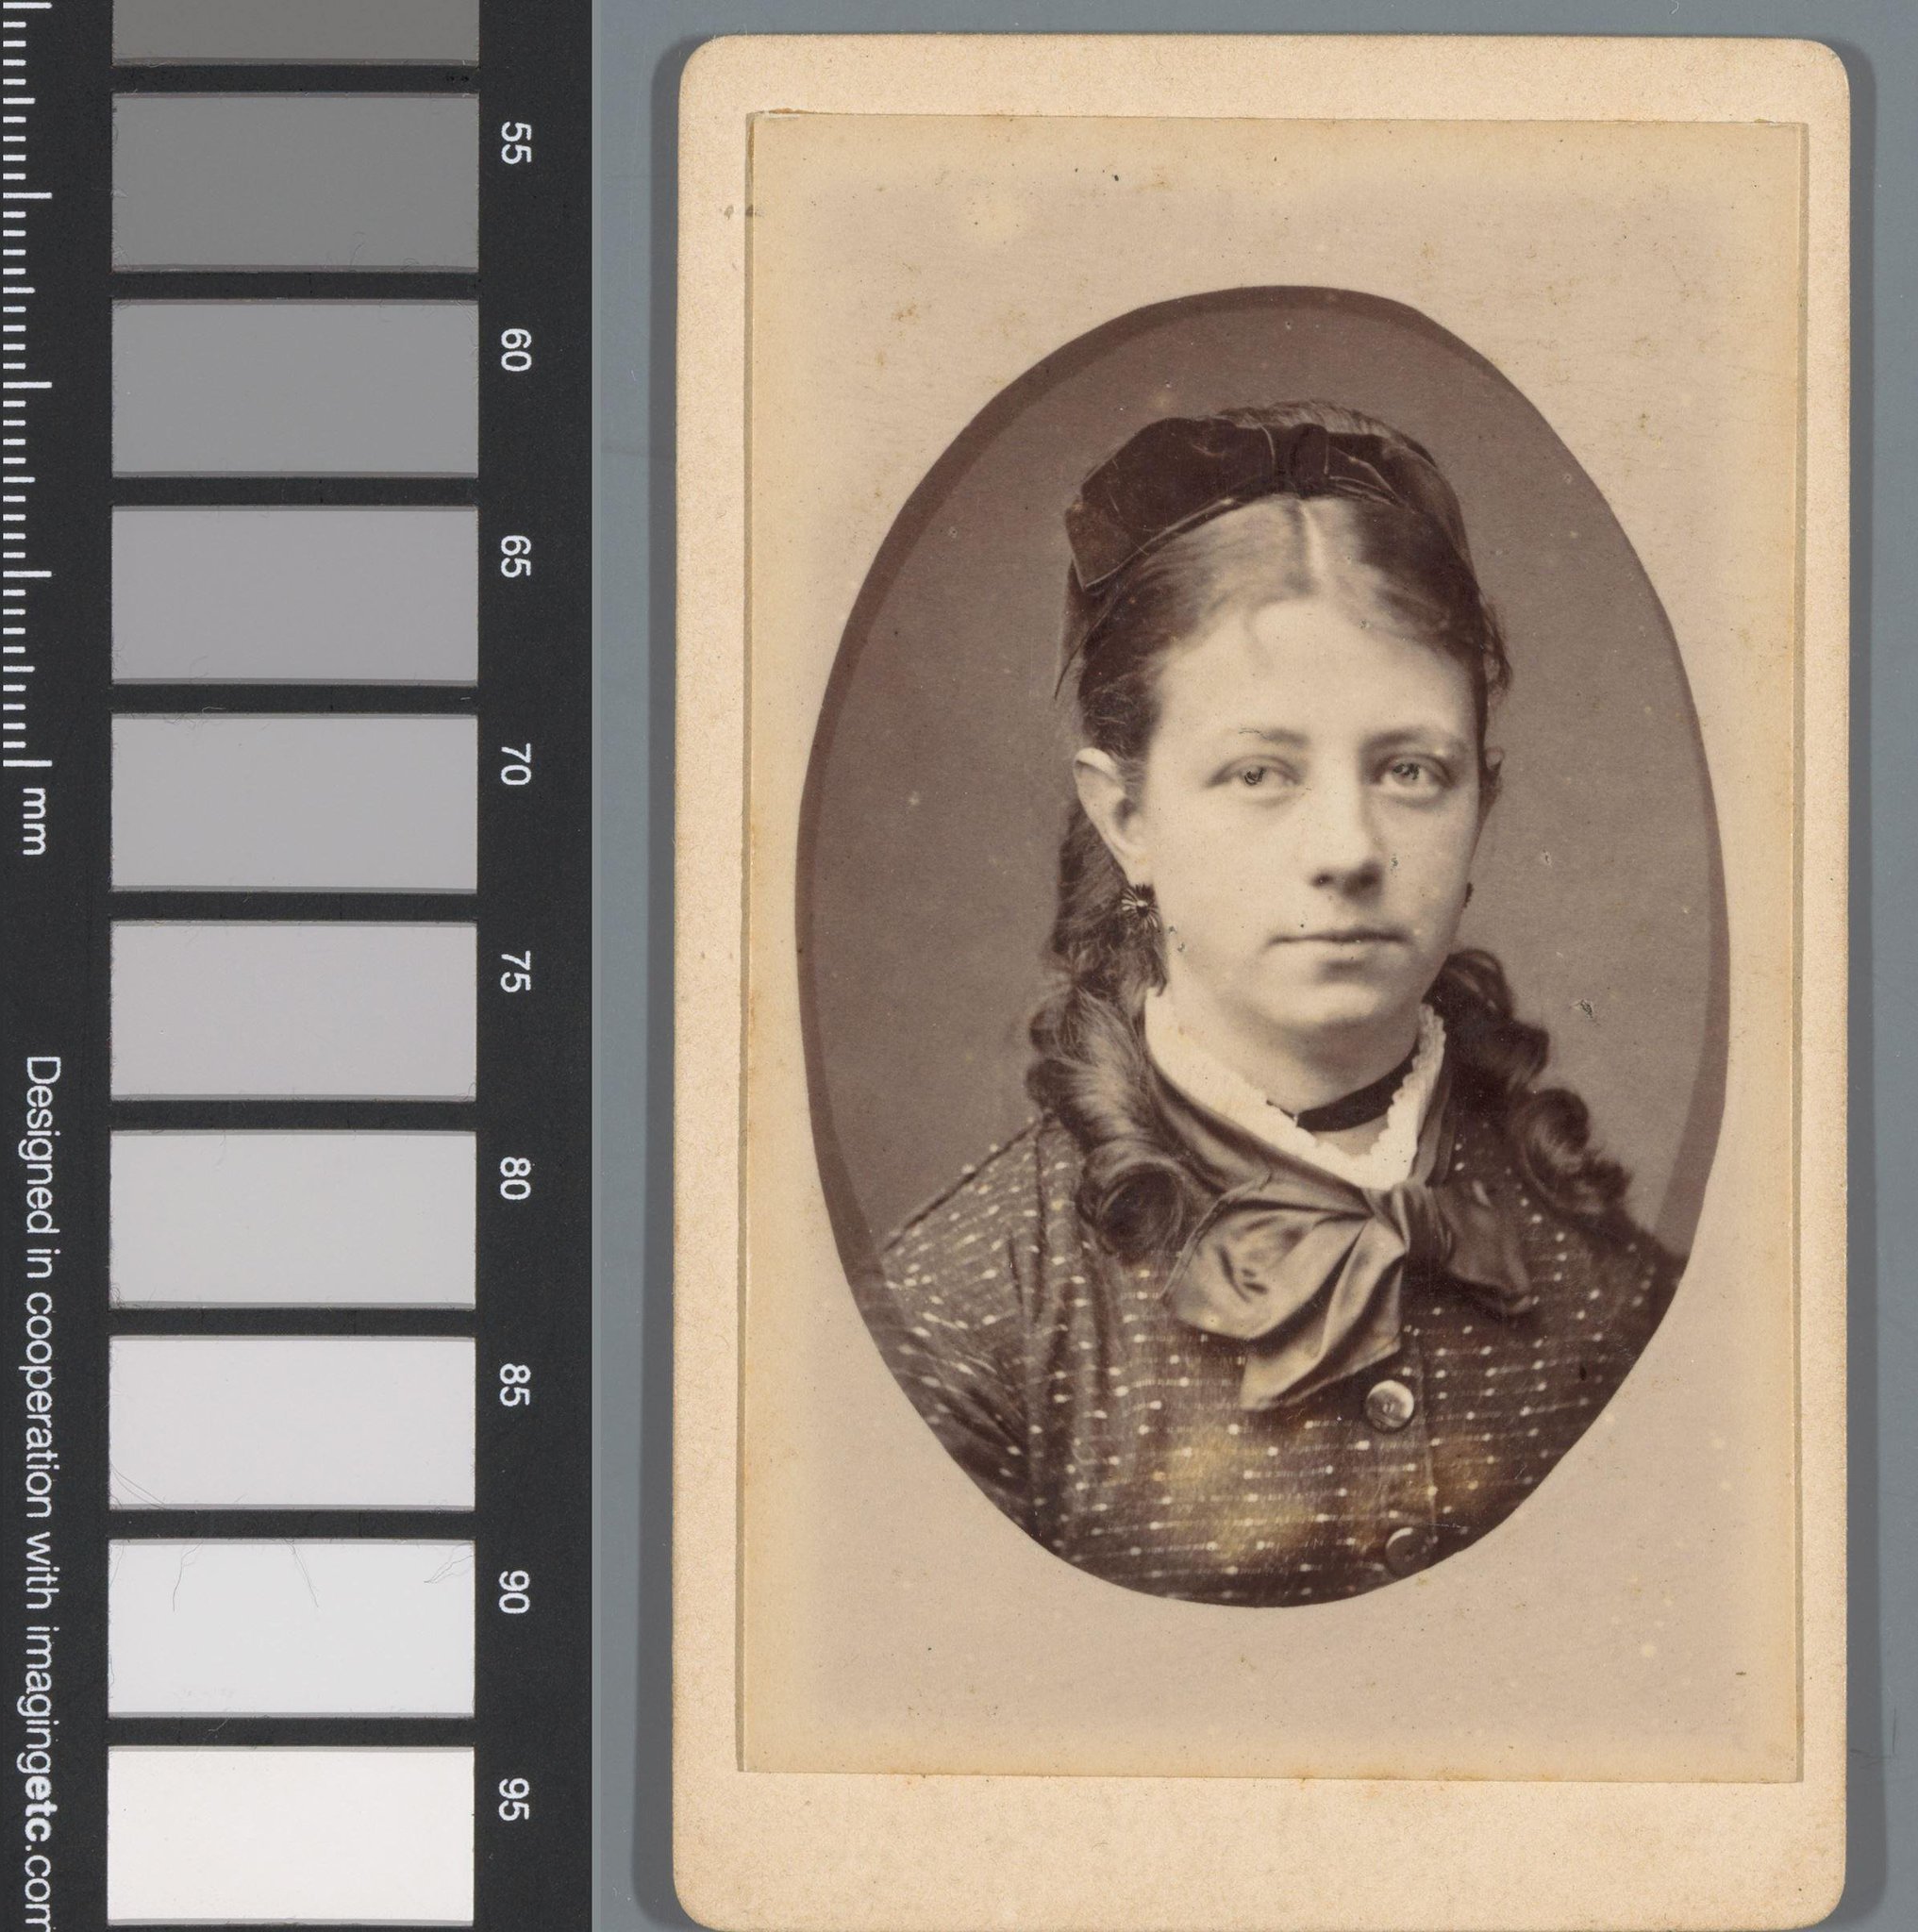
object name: carte de visite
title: Portret van een onbekende vrouw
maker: willem gerhardus kuijer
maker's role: fotograaf, hoffotograaf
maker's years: 1834-1899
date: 1880-1889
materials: cardboard, celluloid, paper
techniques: albumen print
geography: amsterdam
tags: historical persons - bb - woman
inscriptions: inscription: ‘W. G. KUIJER/ Photograaph/ AMSTERDAM/ Rozengracht 72.’